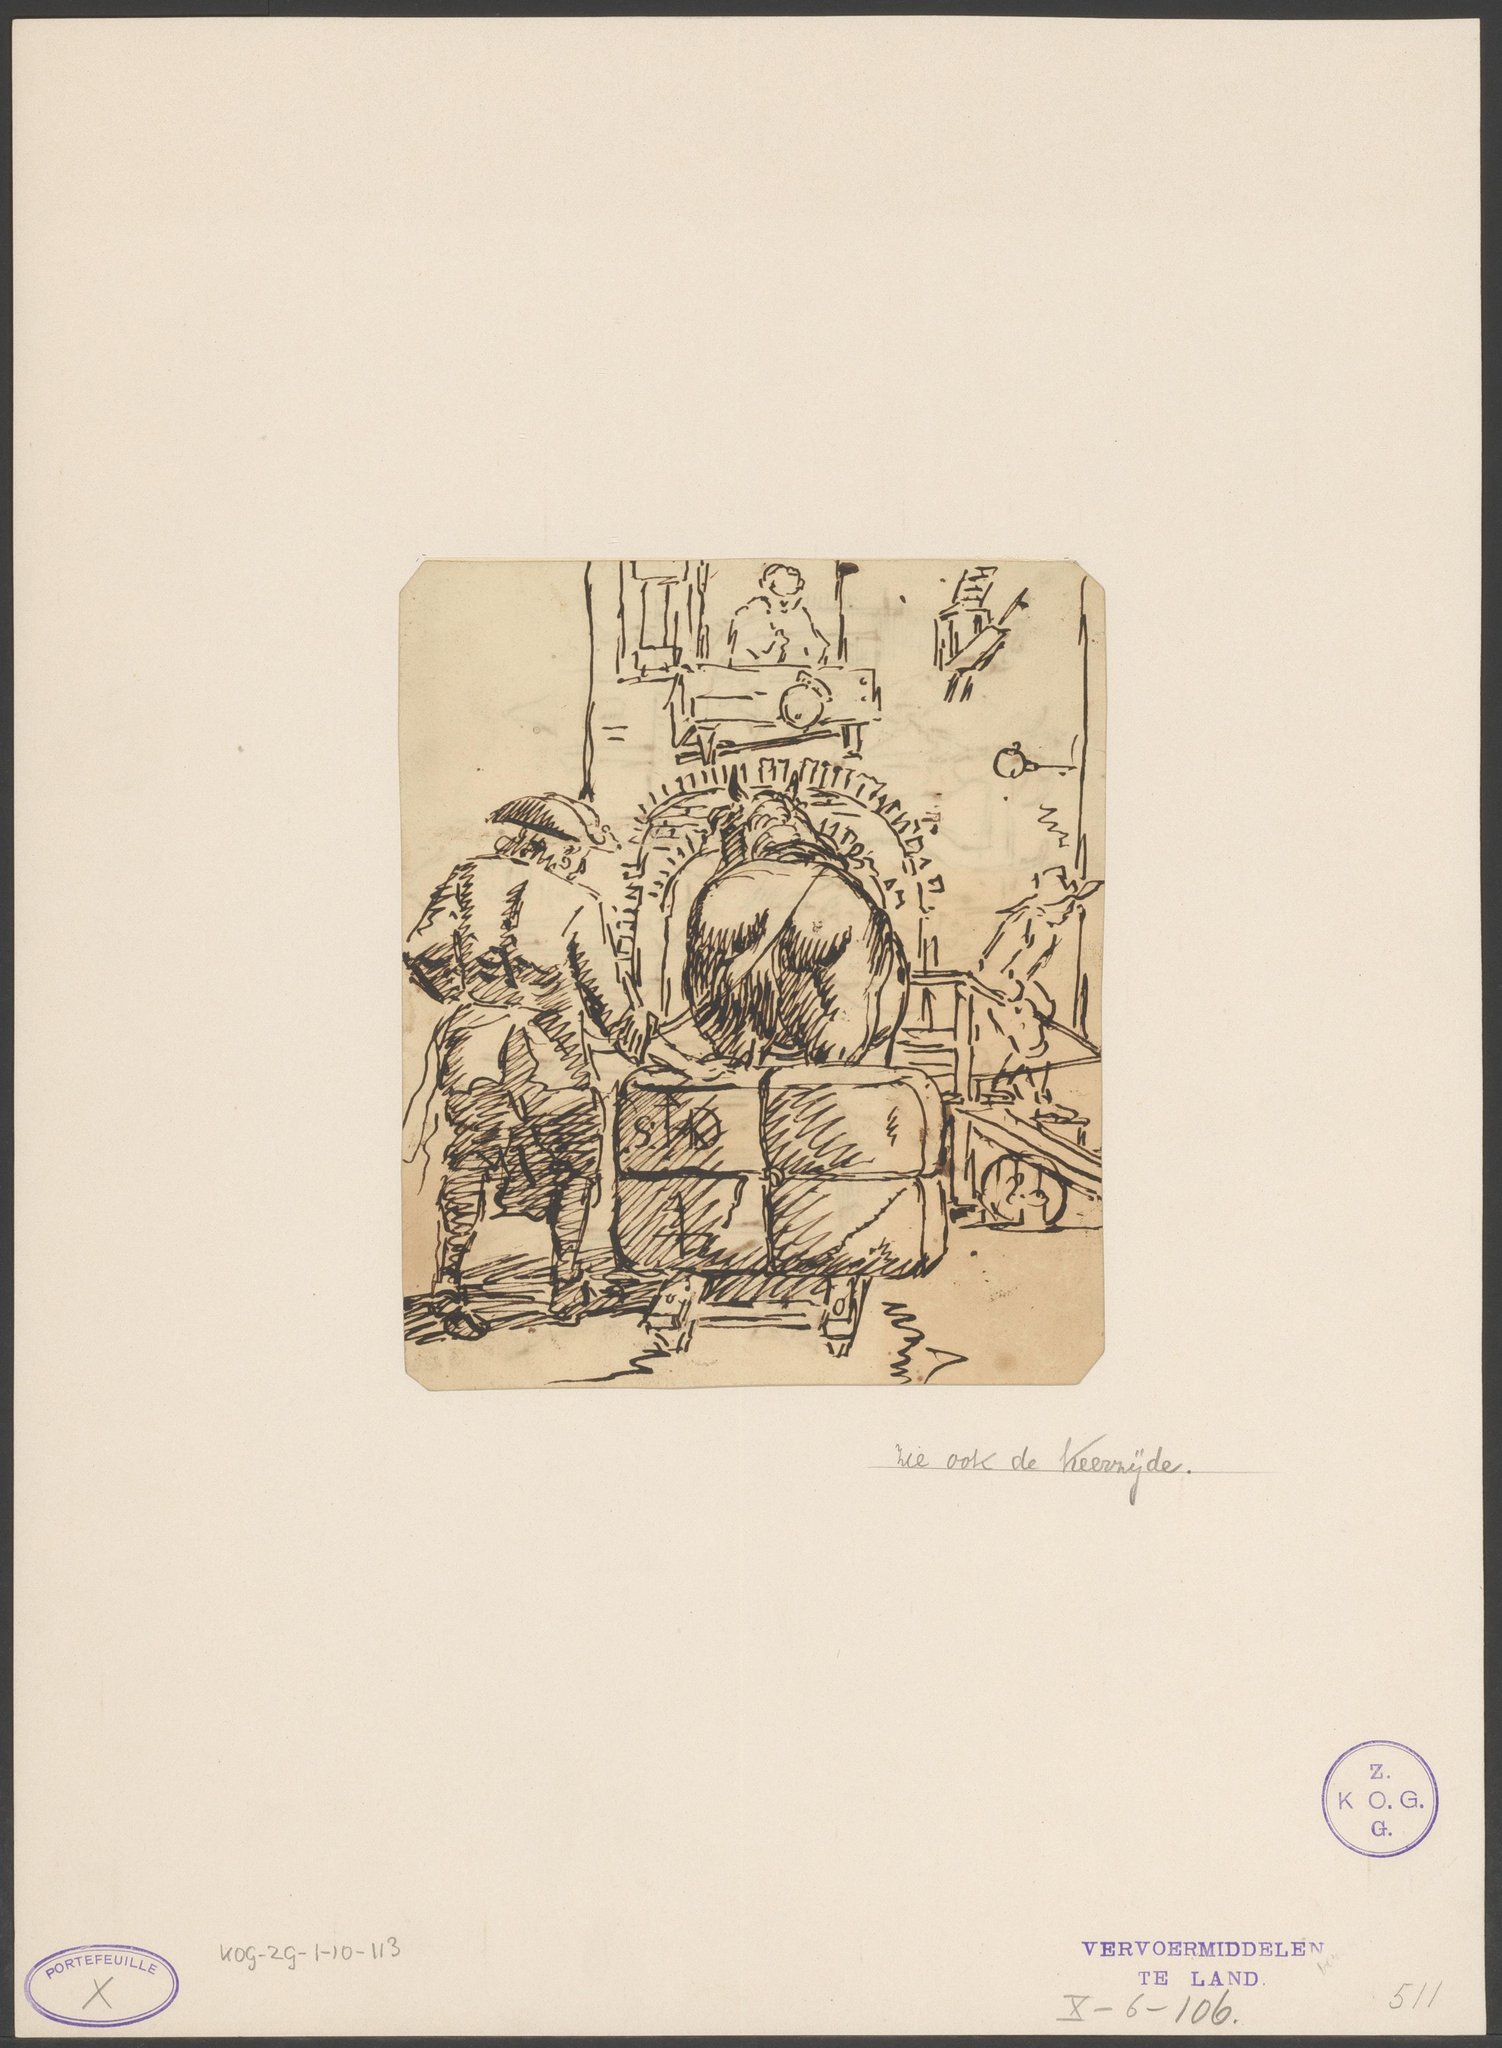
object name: drawing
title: Vrachtslee getrokken door een paard rijdt onder een stadspoort door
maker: Anonymous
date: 1600-1699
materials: ink, paper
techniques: pen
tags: horse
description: Onderwerpsrubrieken binnen de Atlas Zeden en Gewoonten: Handel, nijverheid en verkeer, Vervoermiddelen te land en te water, vervoermiddelen te land, Vrachtwagens.